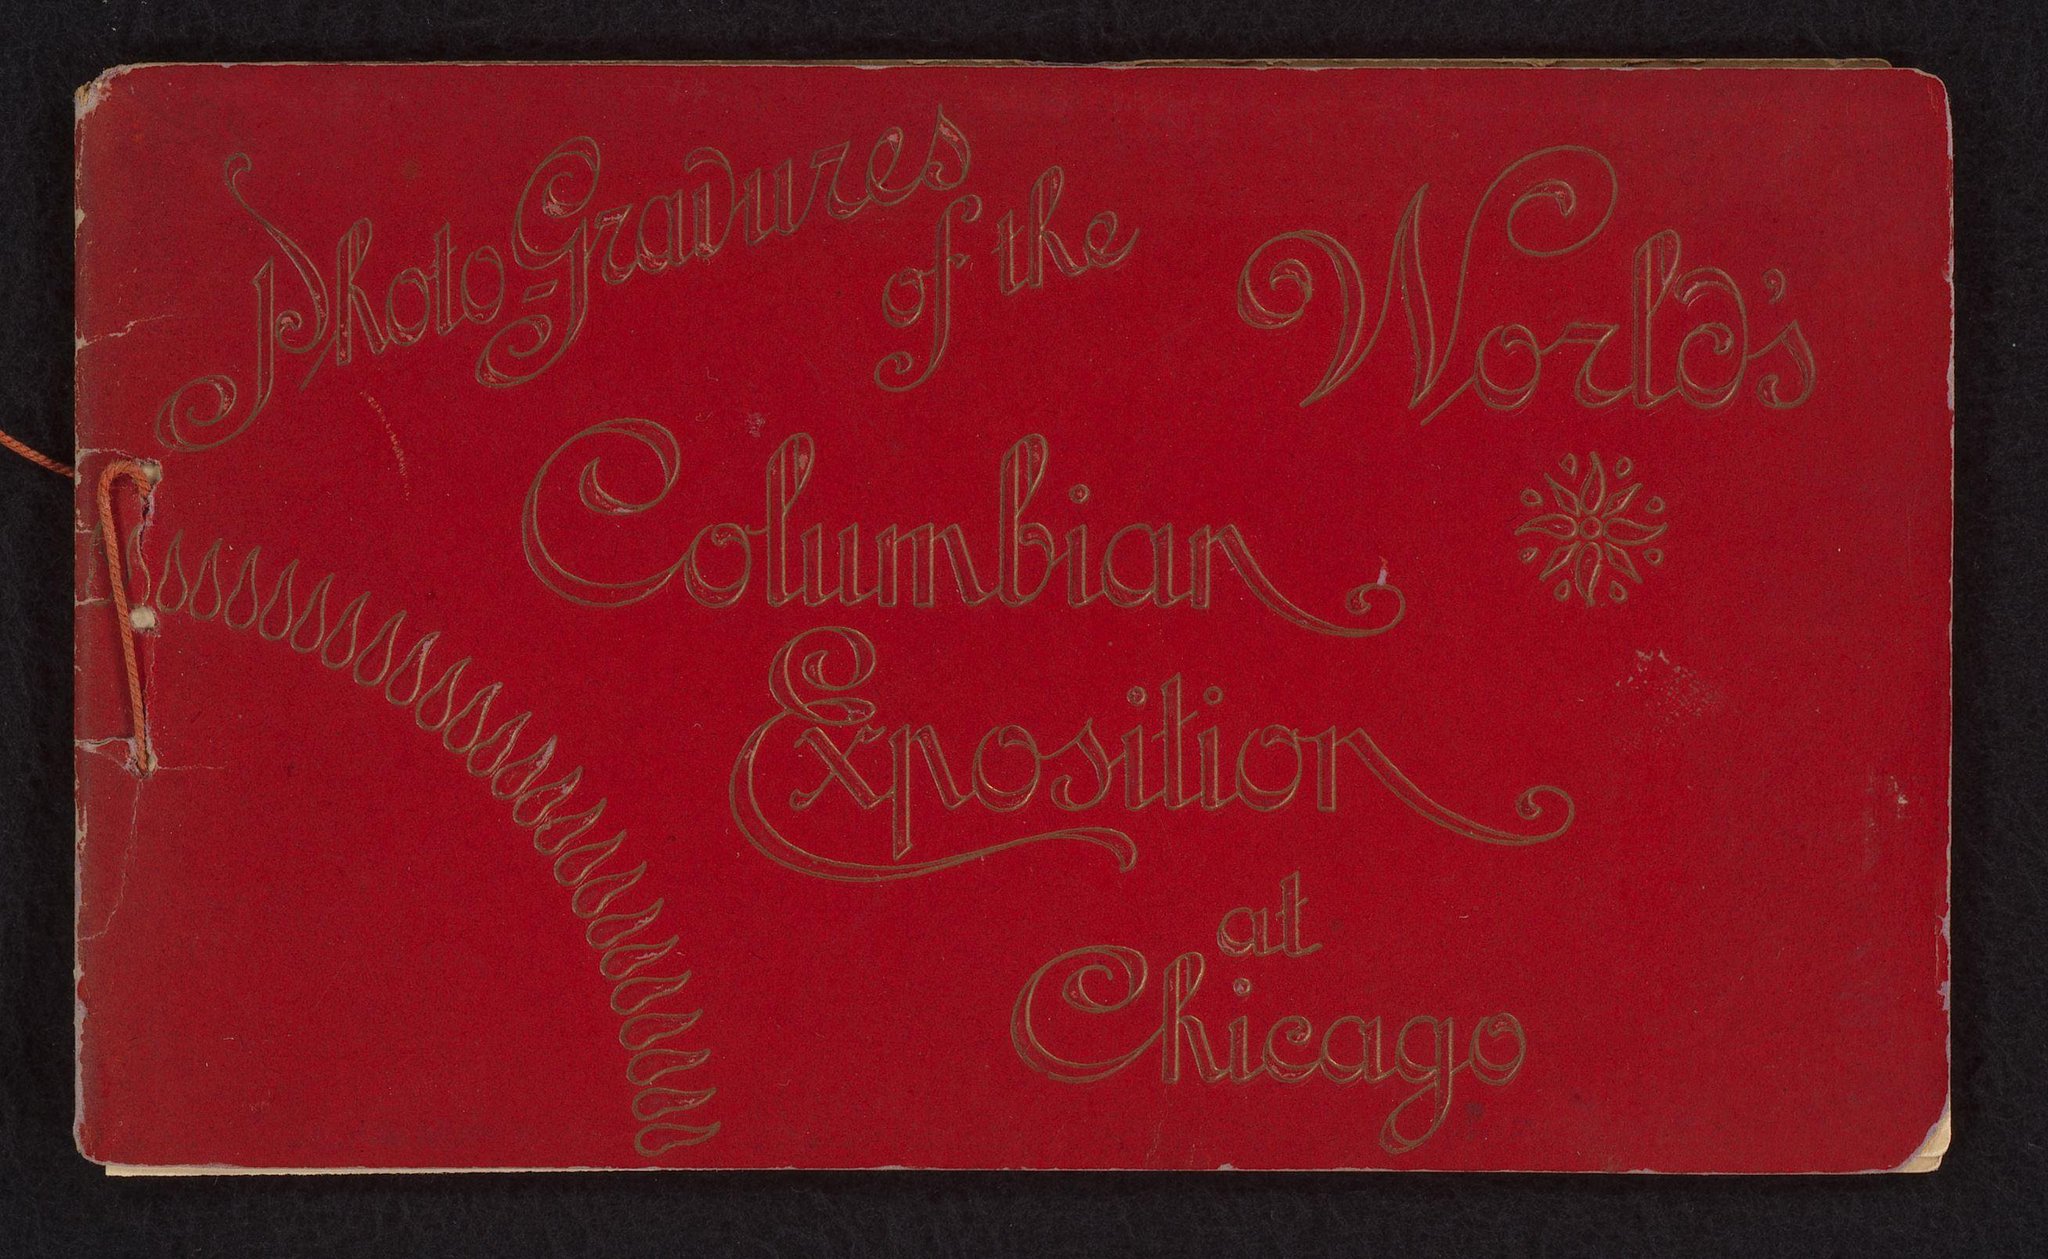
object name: photograph album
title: Souvenir album van de World's Columbian Exposition te Chicago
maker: adolph wittemann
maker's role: publisher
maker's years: 1845-1938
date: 1893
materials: paper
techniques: photograph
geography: chicago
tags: world fair, world exhibition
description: Album met twaalf lichtdrukken van de World's Columbian Exposition, de 11e universele wereldtentoonstelling, gehouden in Chicago.